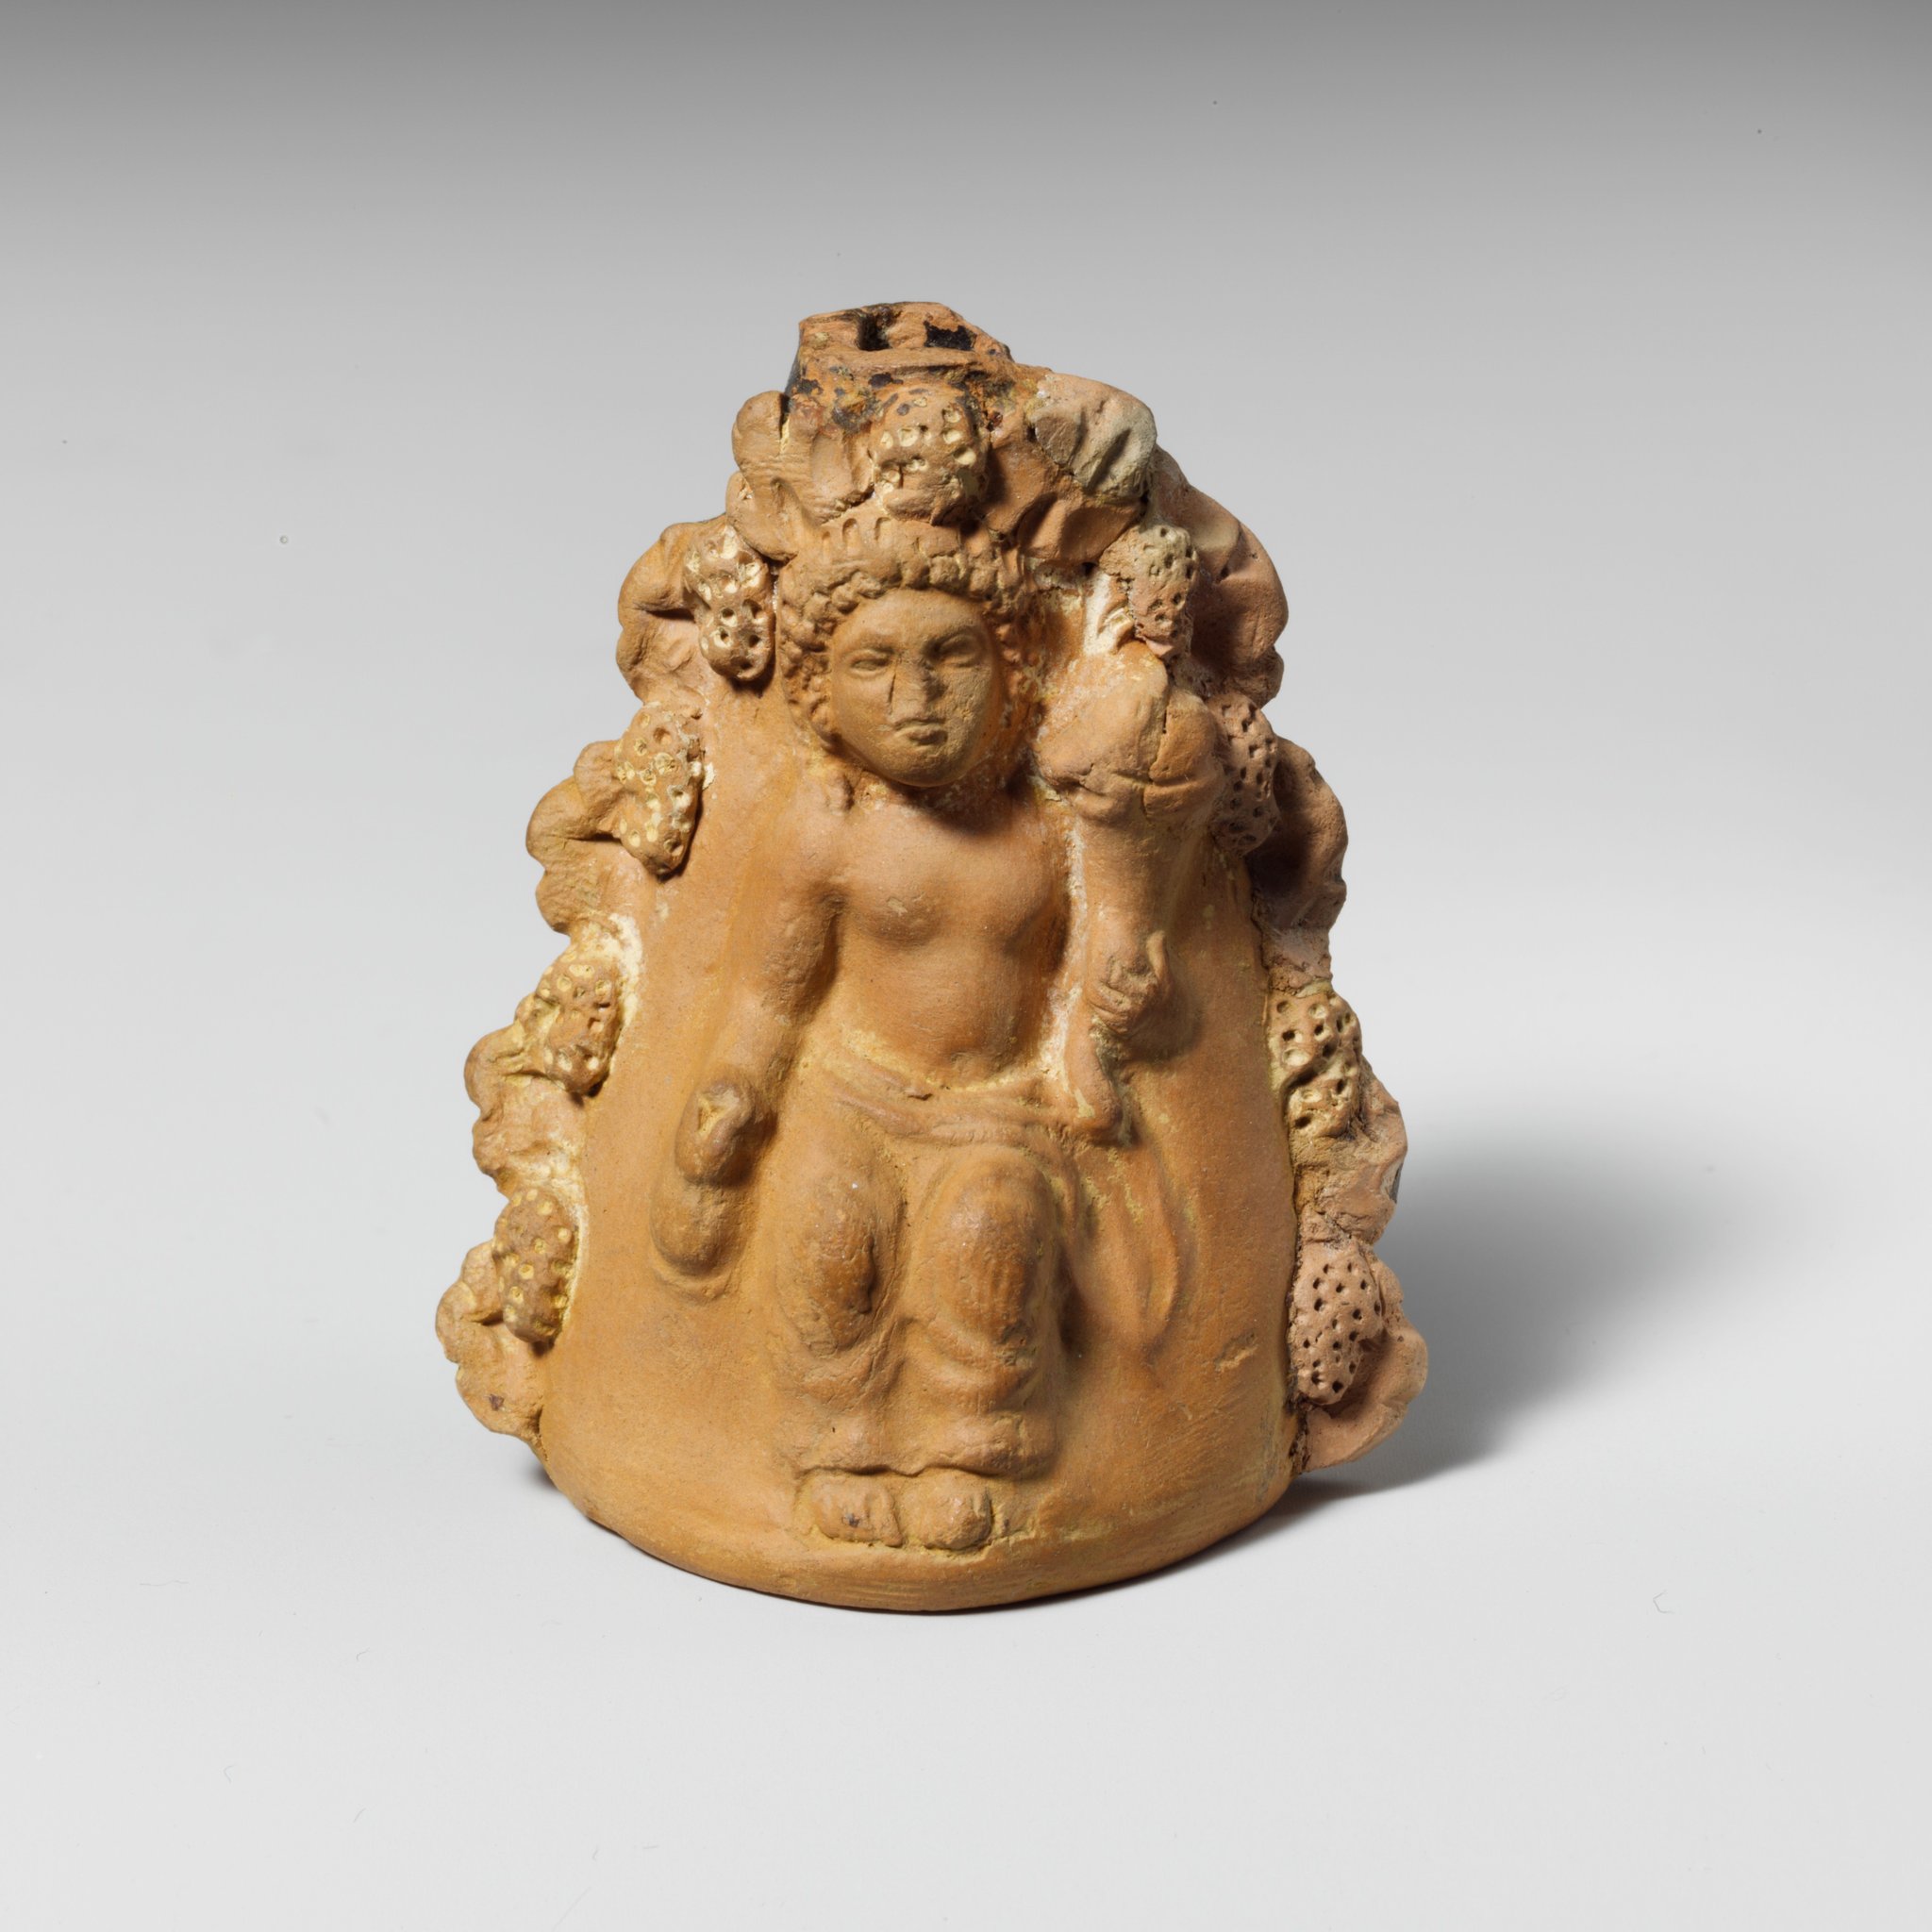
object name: oinochoe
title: Terracotta oinochoe (jug) with a seated boy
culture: greek, attic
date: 400-301 BCE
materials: terracotta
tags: boys,cornucopia